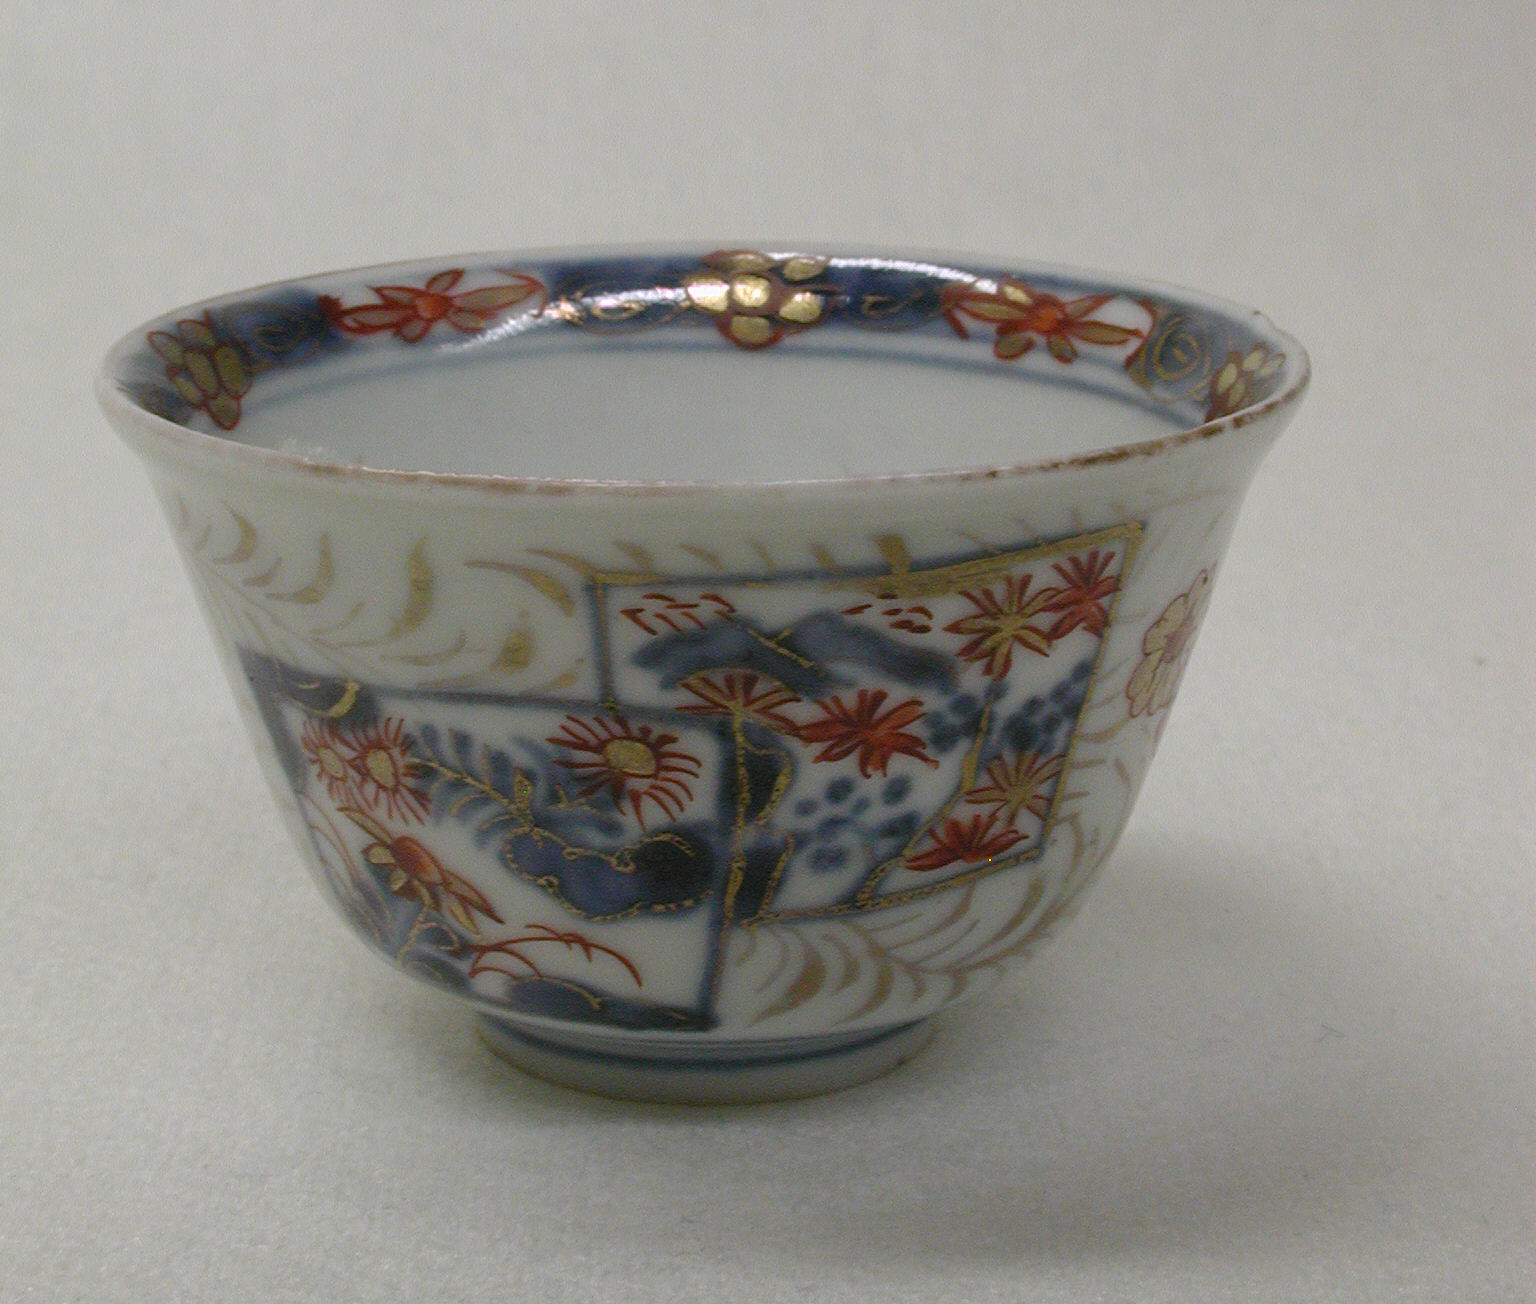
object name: cup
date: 1701-1800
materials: porcelain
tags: flowers